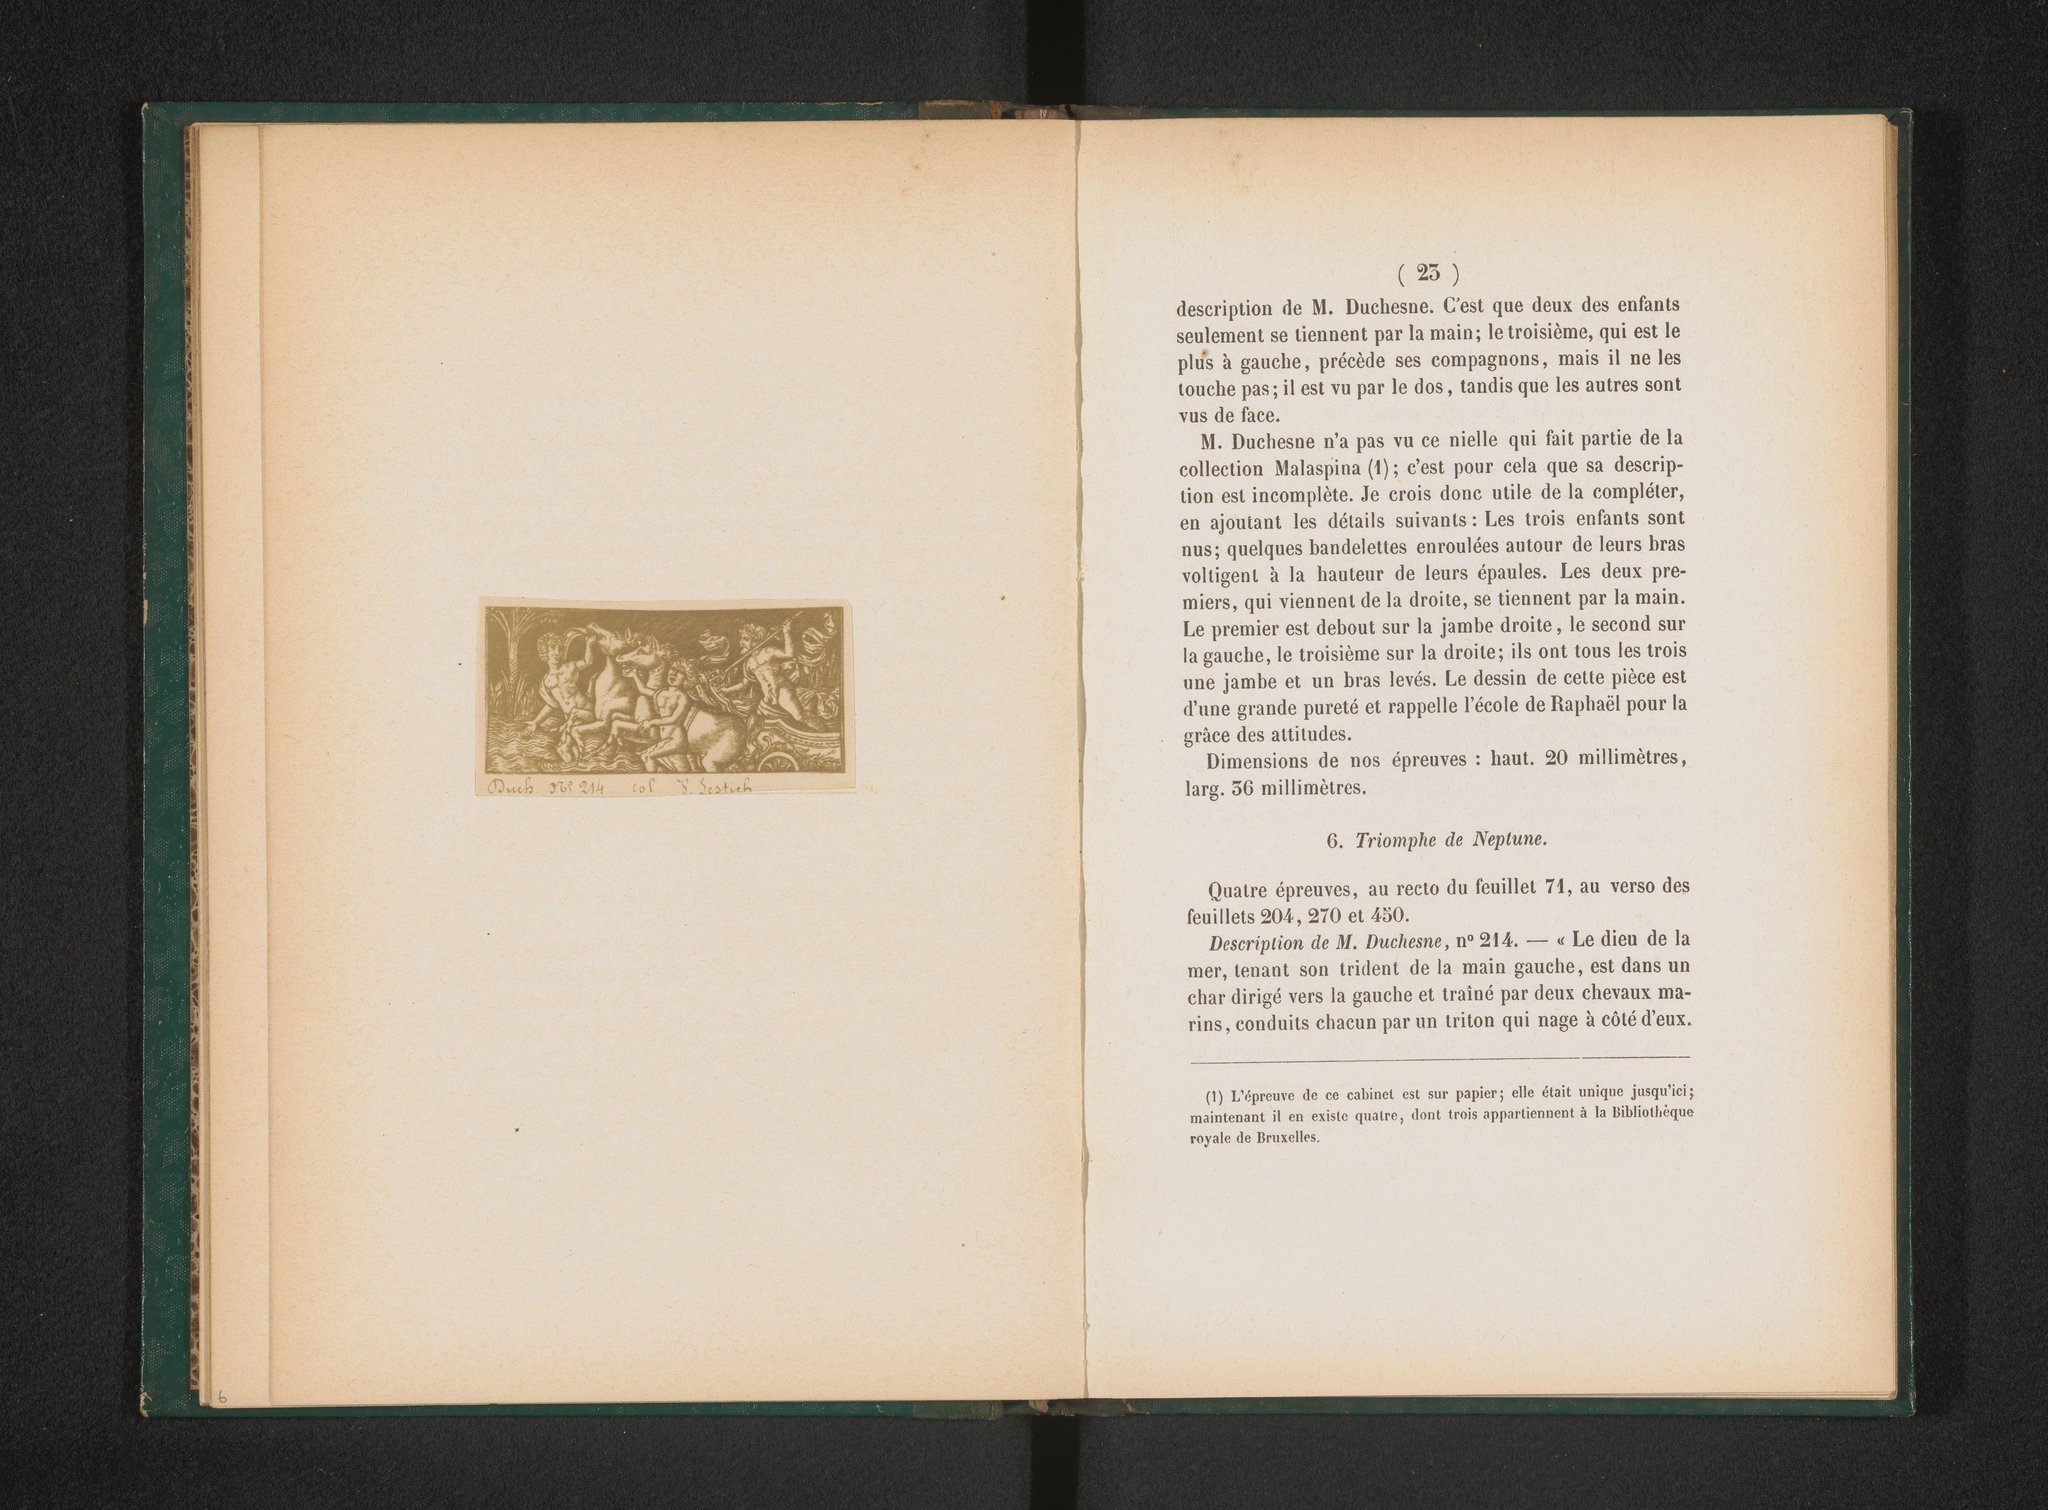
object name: photograph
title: Fotoreproductie van een prent van de triomf van Neptunus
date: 1852-1857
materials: photographic support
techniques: salted paper print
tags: triumph of neptune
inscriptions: inscription: ‘Duch. No. 214. col. V. Sestich’